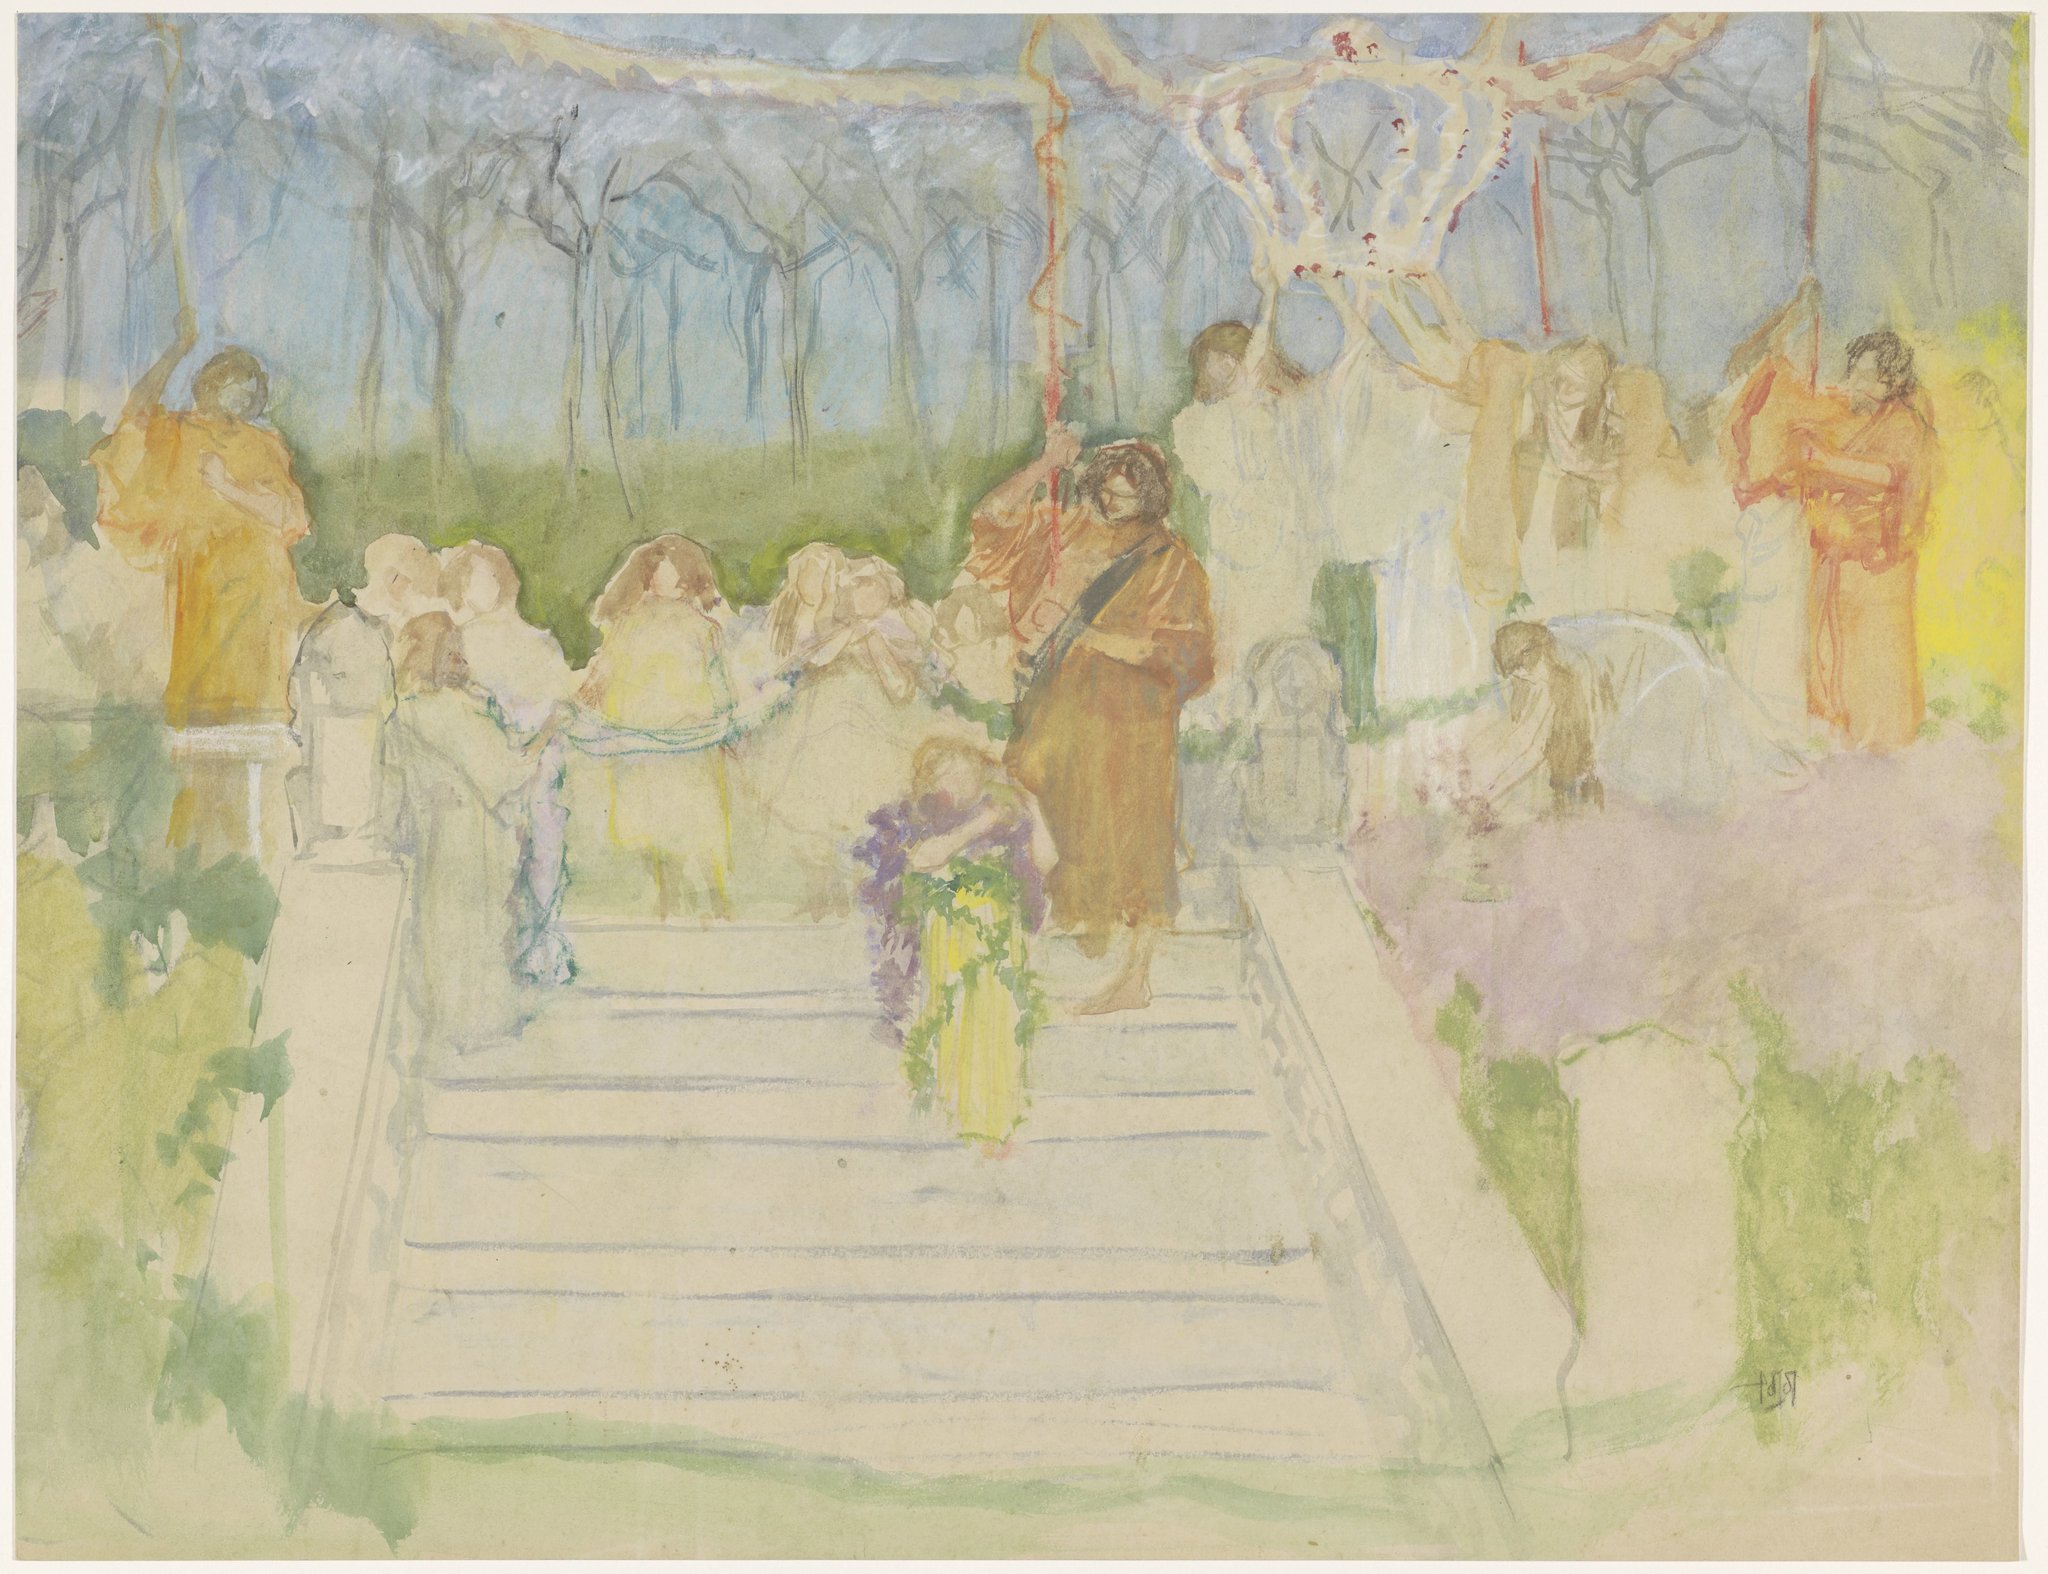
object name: drawing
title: Tableau vivant ter gelegenheid van het huwelijk van koningin Wilhelmina in 1901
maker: pieter de josselin de jong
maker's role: draughtsman, painter, print maker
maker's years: 1861-1906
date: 1871-1906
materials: chalk, paper, watercolor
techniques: brush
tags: the hague, print maker, wilhelmina of the netherlands, hendrik (prins der nederlanden (1876-1934)), 'tableau vivant', wedding feast, wedding meal, historical persons, public festivities at marriage of royal persons, historical events and situations